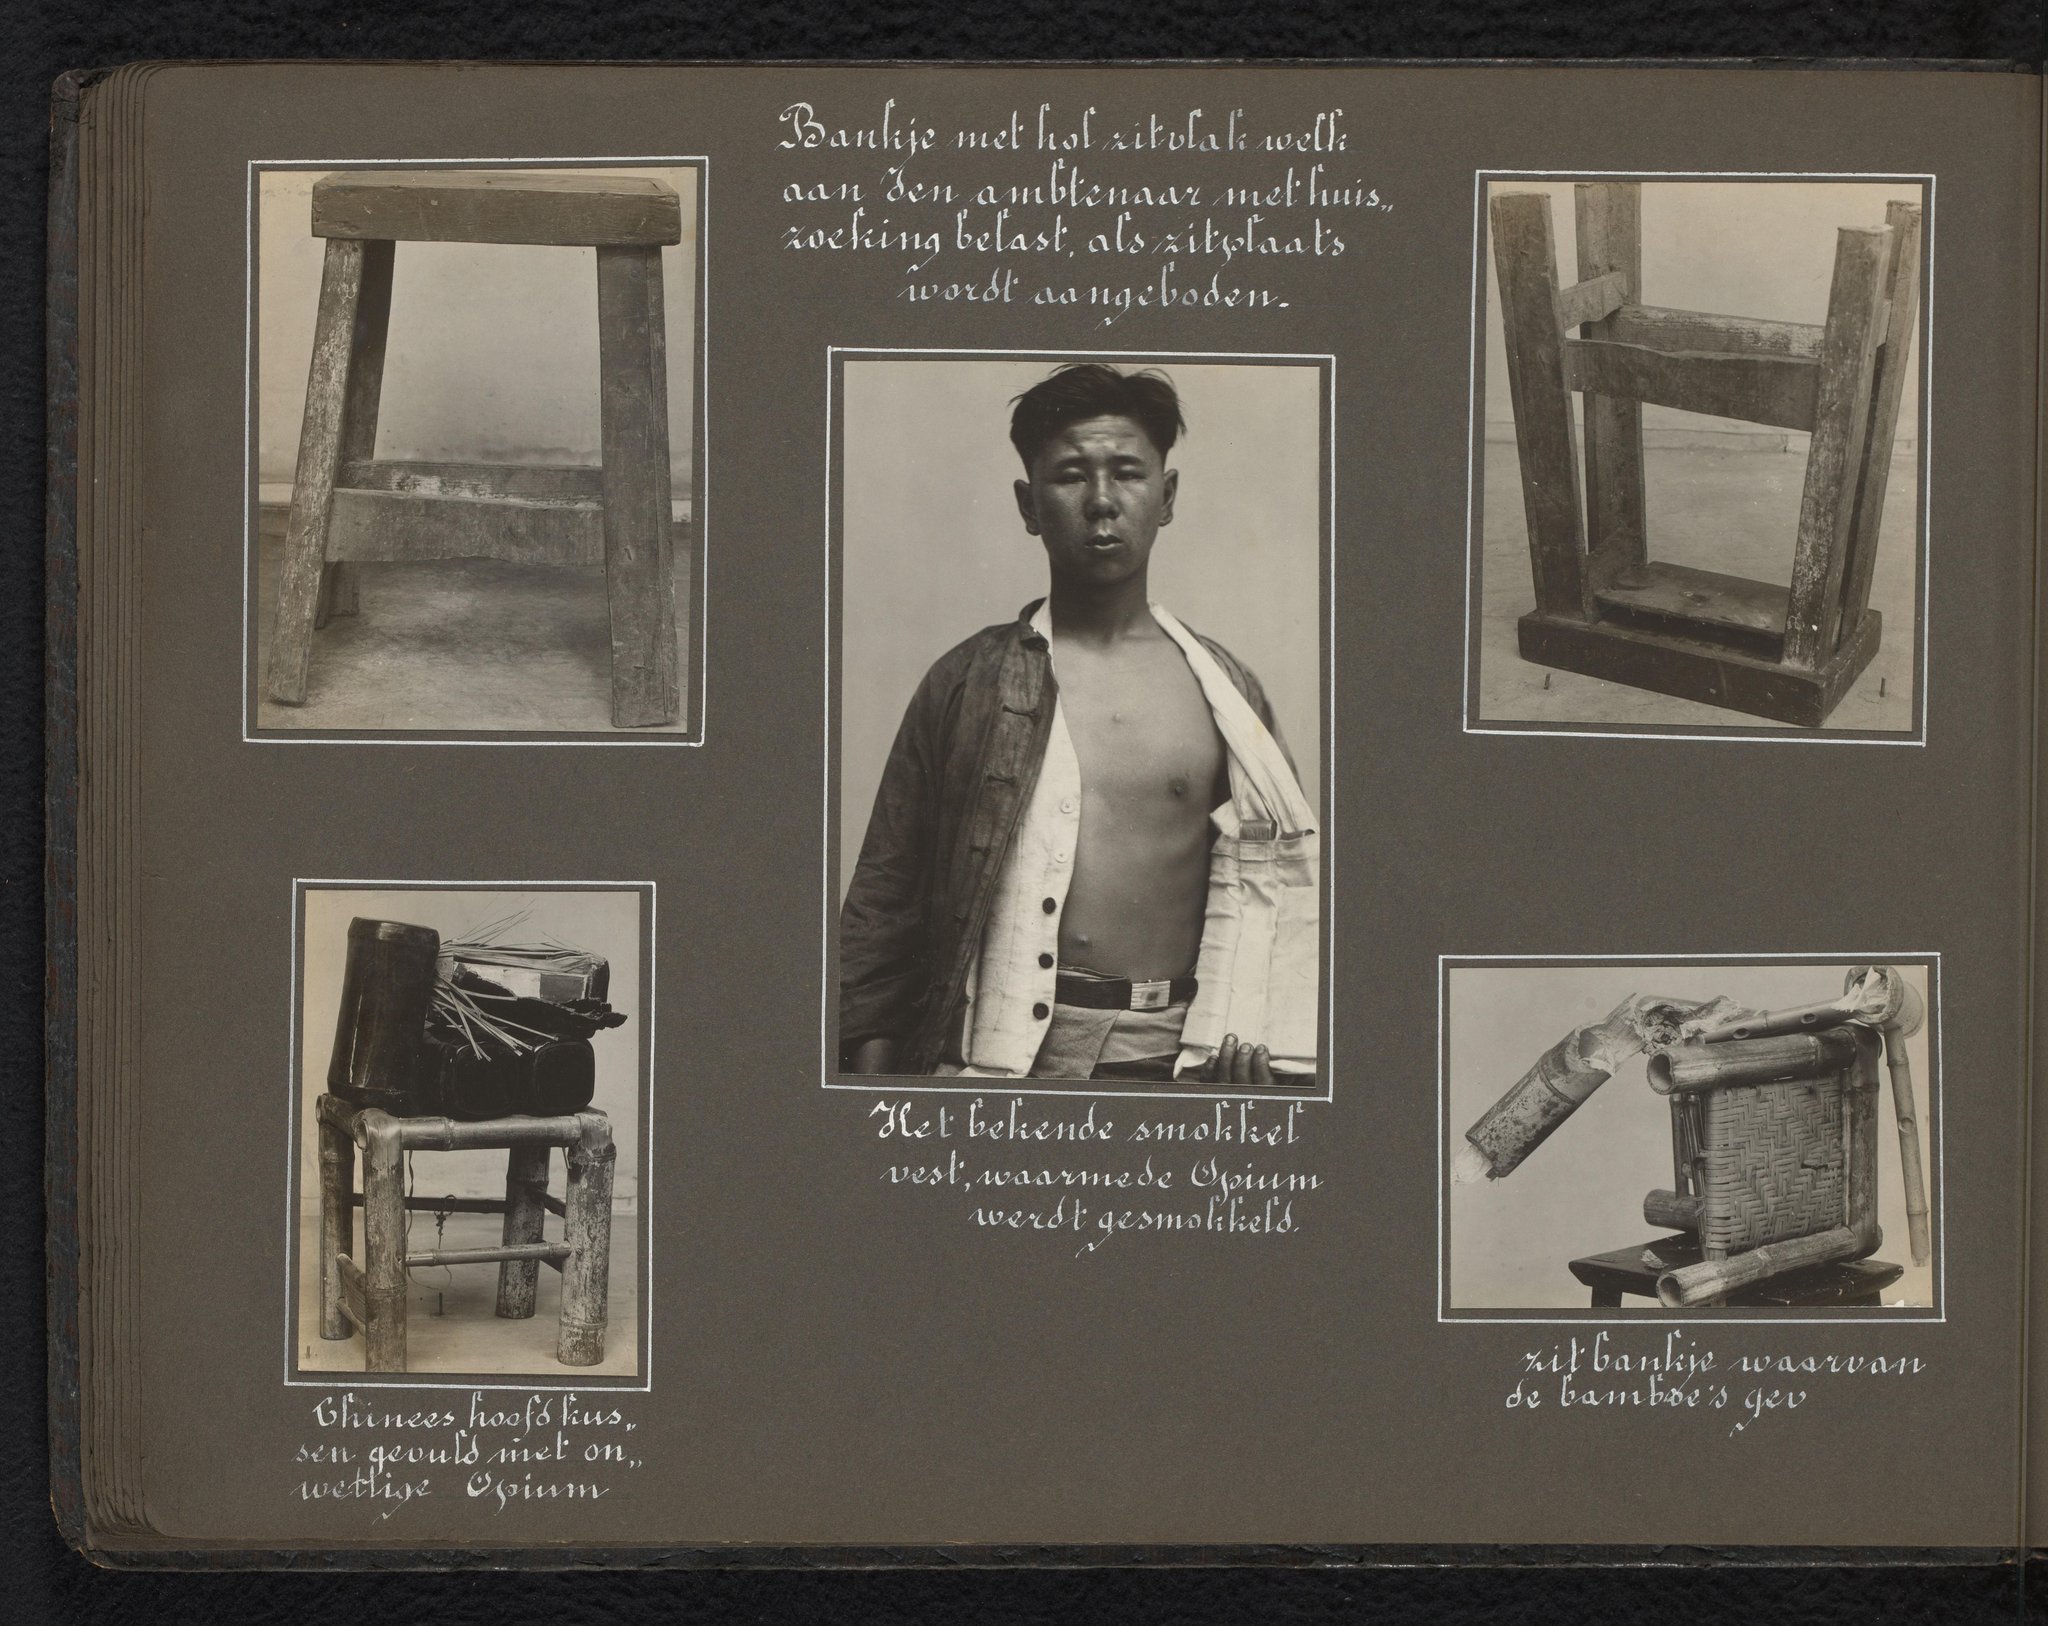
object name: album leaf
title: Verbergplaatsen voor opium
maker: Anonymous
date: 1920-1930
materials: cardboard, photographic support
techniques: gelatin silver print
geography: dutch east indies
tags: opium, trade and smuggling of drugs, policeman, constable, dutch east indies, the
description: Albumblad met vijf foto's van een kruk en bankje waarin opium werd verstopt en van een man met een smokkelvest voor opium. Onderdeel van het fotoalbum uit 1930 met politiefoto's over de opiumsmokkel in Indië.